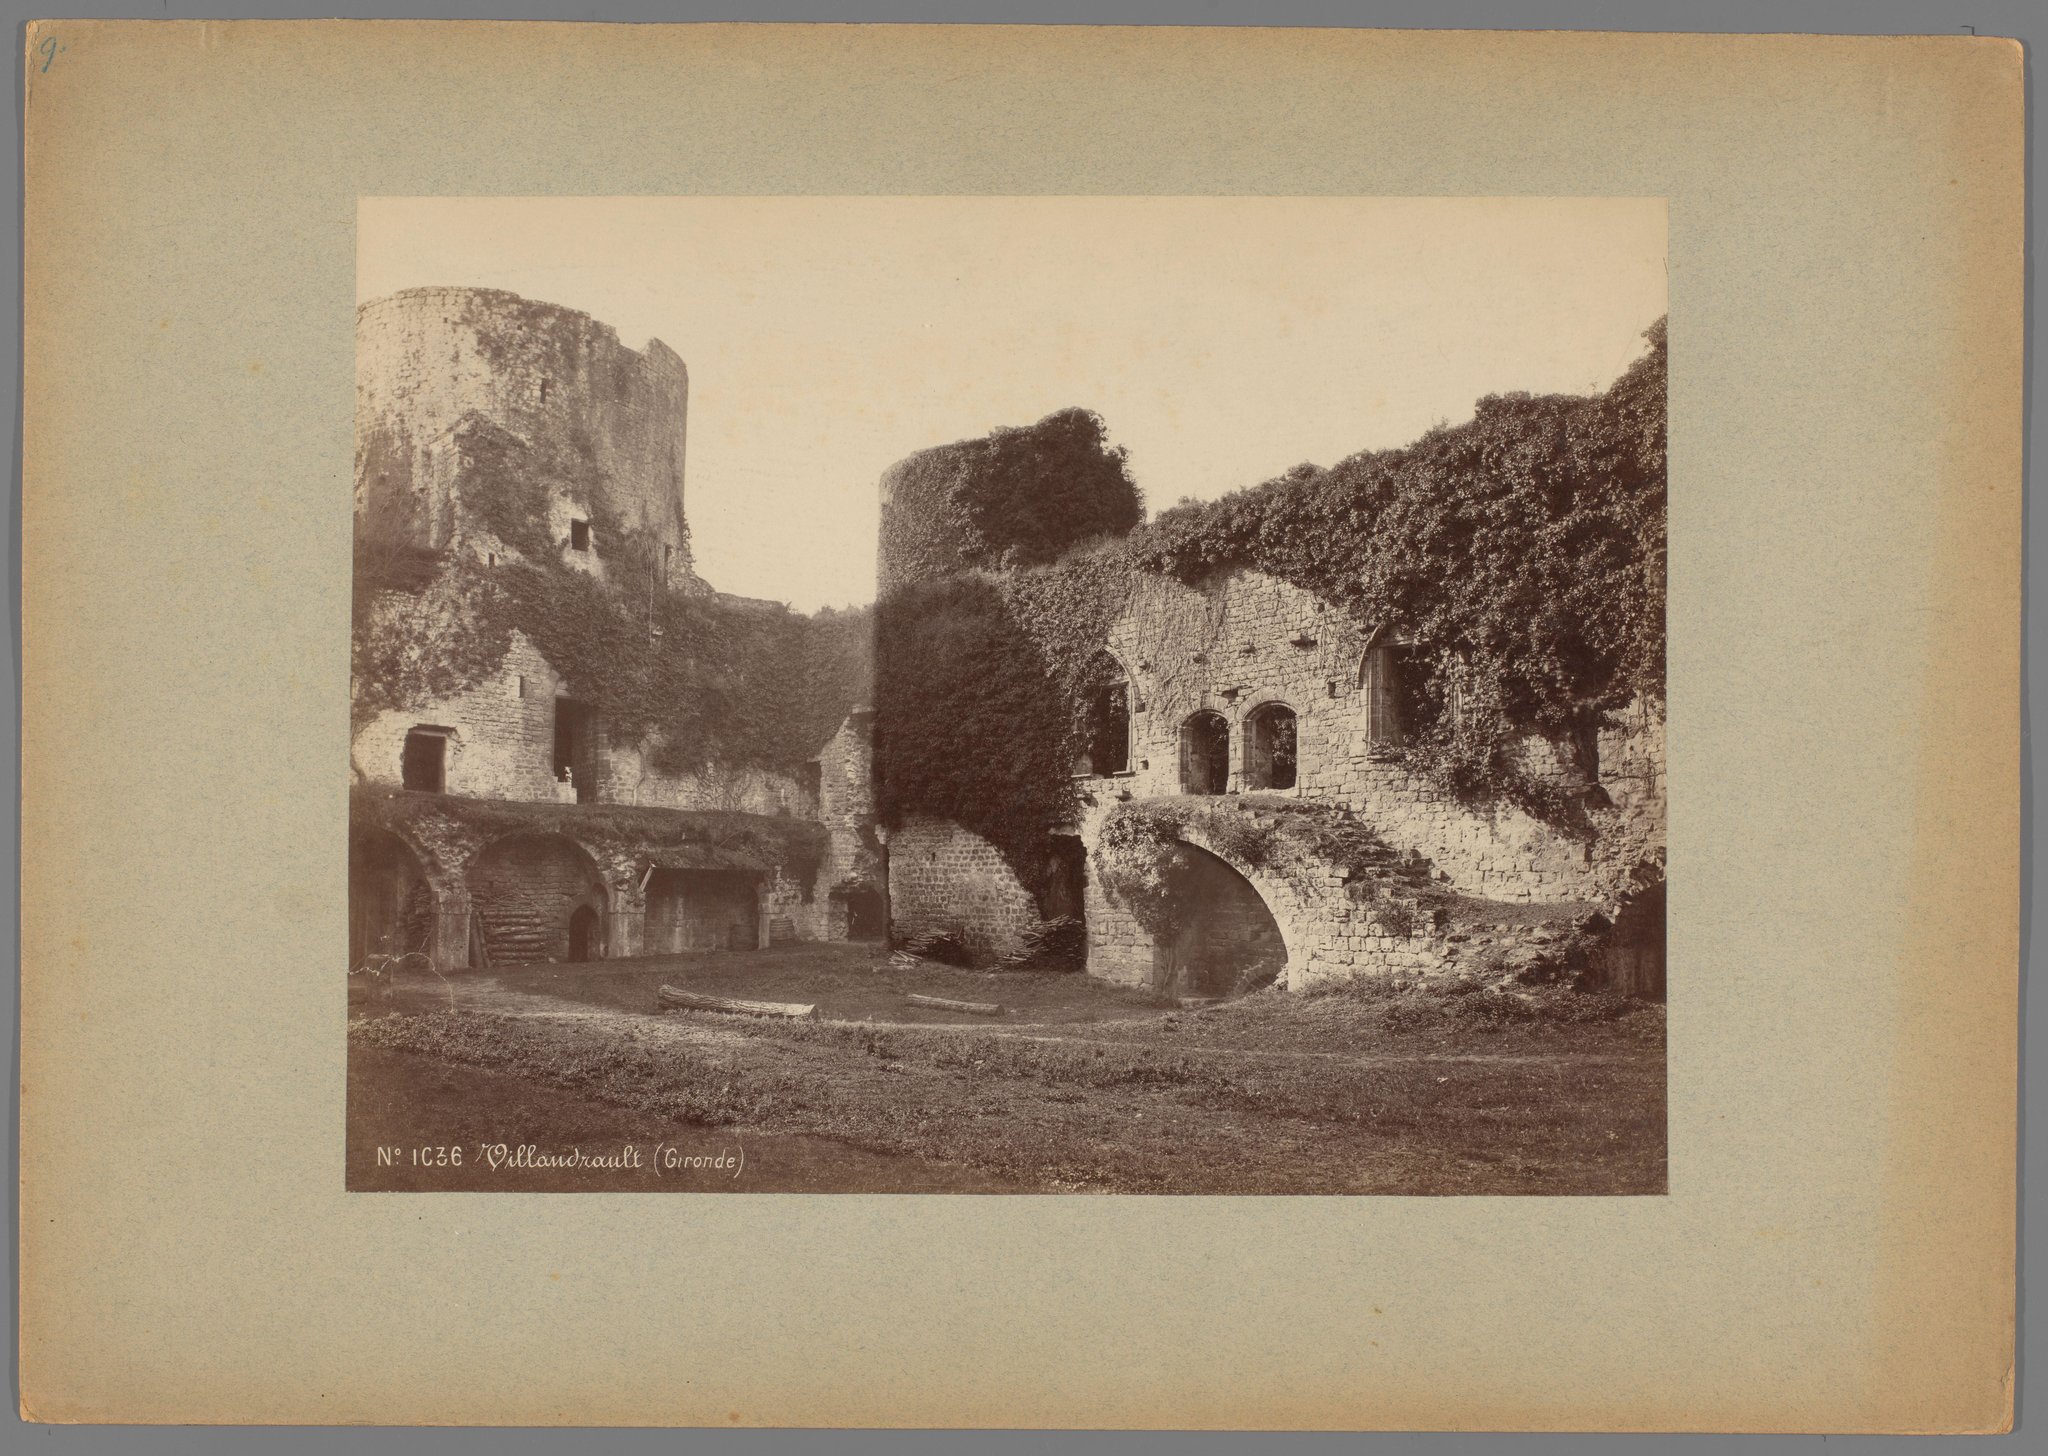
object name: photograph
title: Gezicht op een ruïne van een kasteel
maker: j.a.g. de leur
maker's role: publisher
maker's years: 1860-1914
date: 1850-1900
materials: cardboard, photographic support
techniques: albumen print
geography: villandraut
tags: castle, ruin of a building ~ architecture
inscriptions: check stamp: ‘[...]’, collector's mark: ‘Rijks-normaalschool voor teekenonderwijzers Amsterdam’, inscription: ‘(Gironde)’, workshop stamp: ‘Kunsthandel/ J.A.G. de Leur/ Photograaf- Uitgever/ Huigenspark, 40b,/ Den Haag’, number: ‘No. 1636’